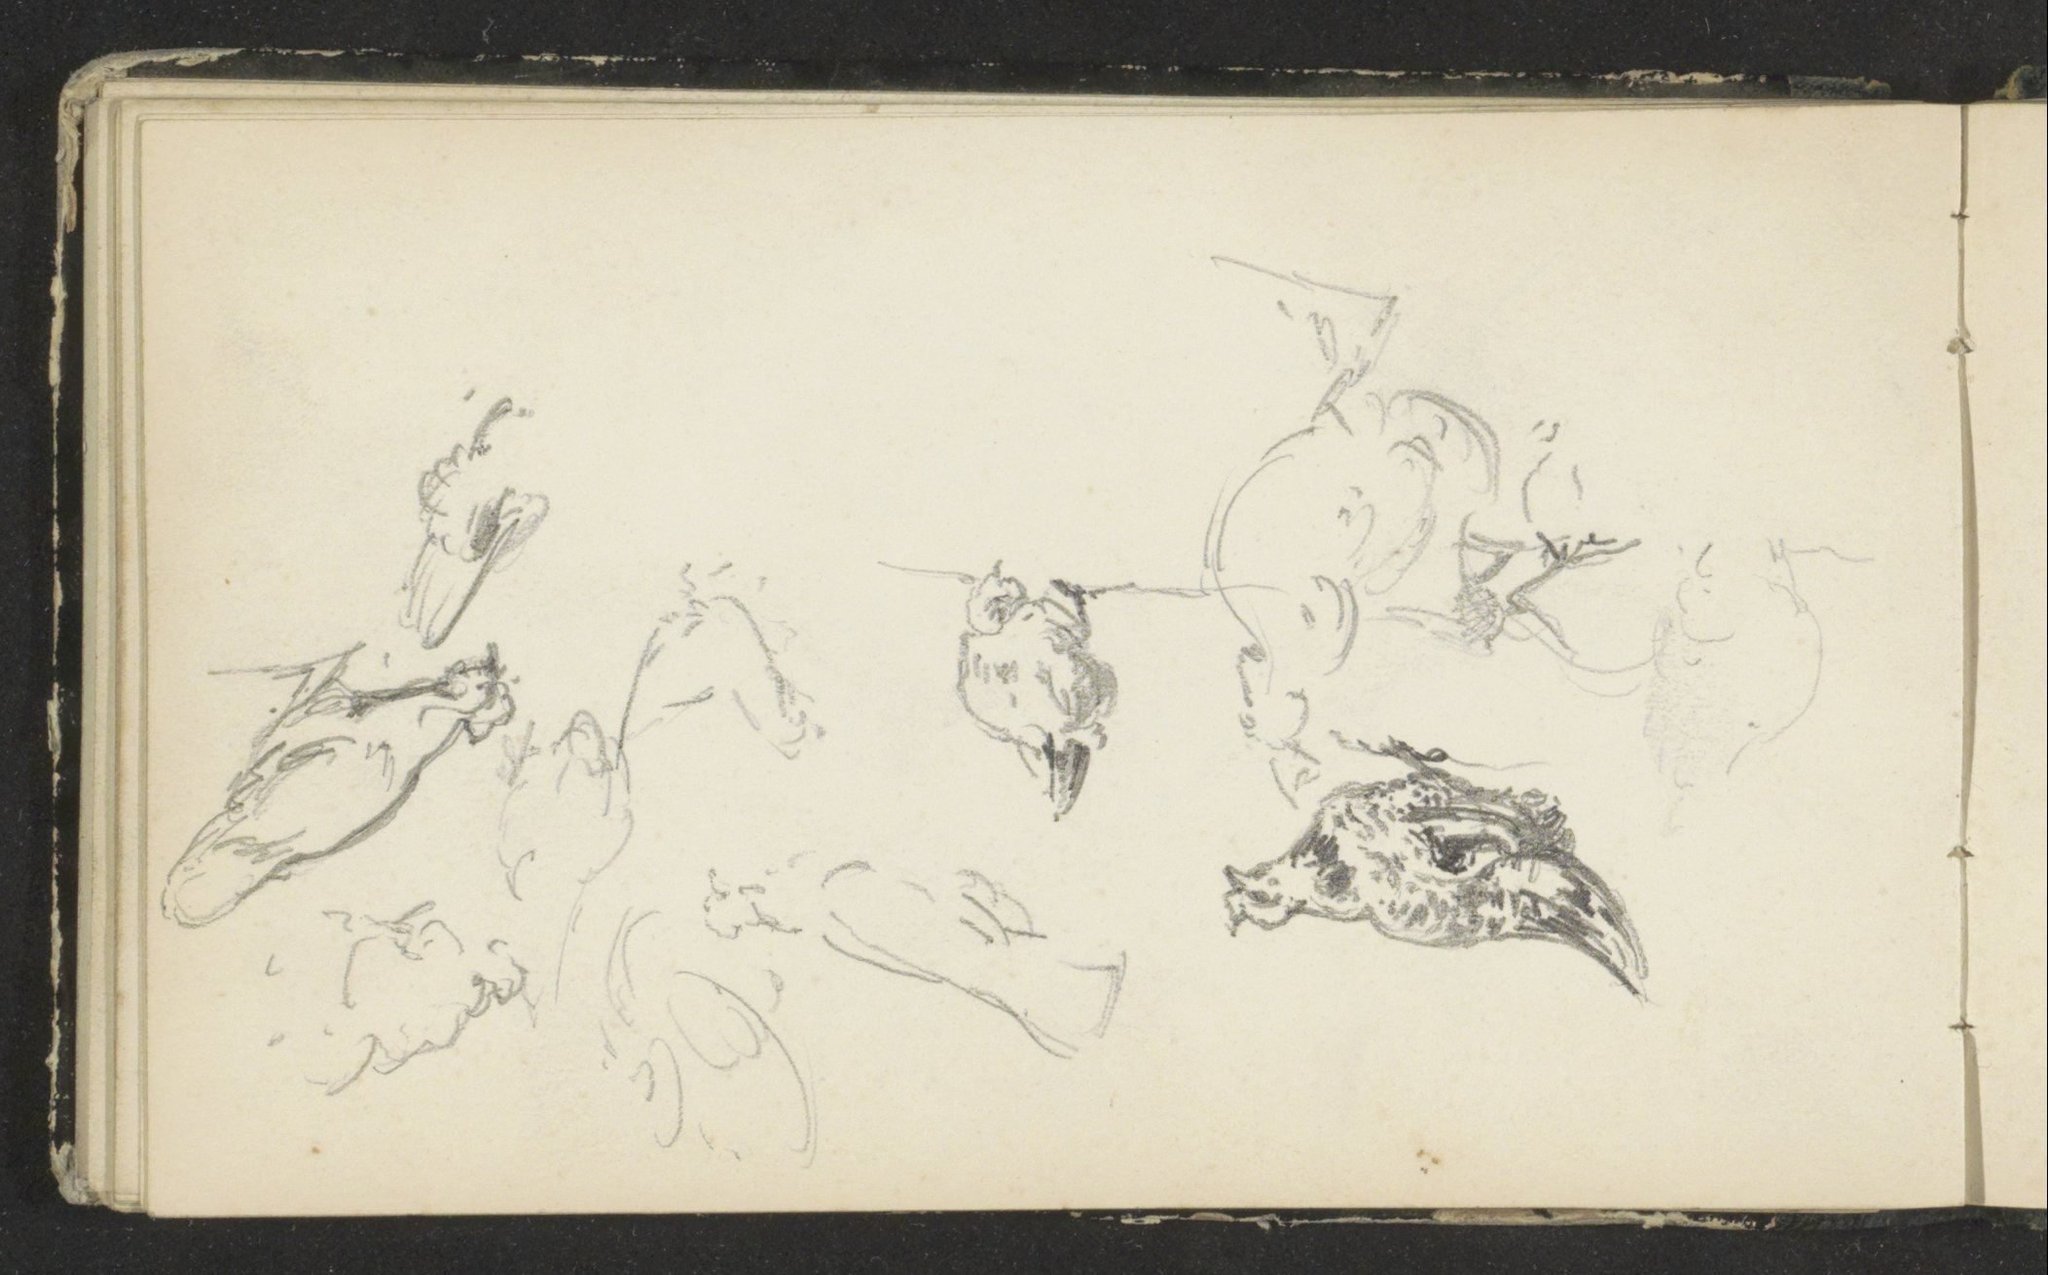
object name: sketchbook leaf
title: Kippen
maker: maria vos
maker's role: draughtsman, painter, print maker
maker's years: 1824-1906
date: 1834-1906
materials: paper, pencil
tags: fowl (cock, hen, chicken, etc.)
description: Blad 26 verso uit een schetsboek met 46 bladen.